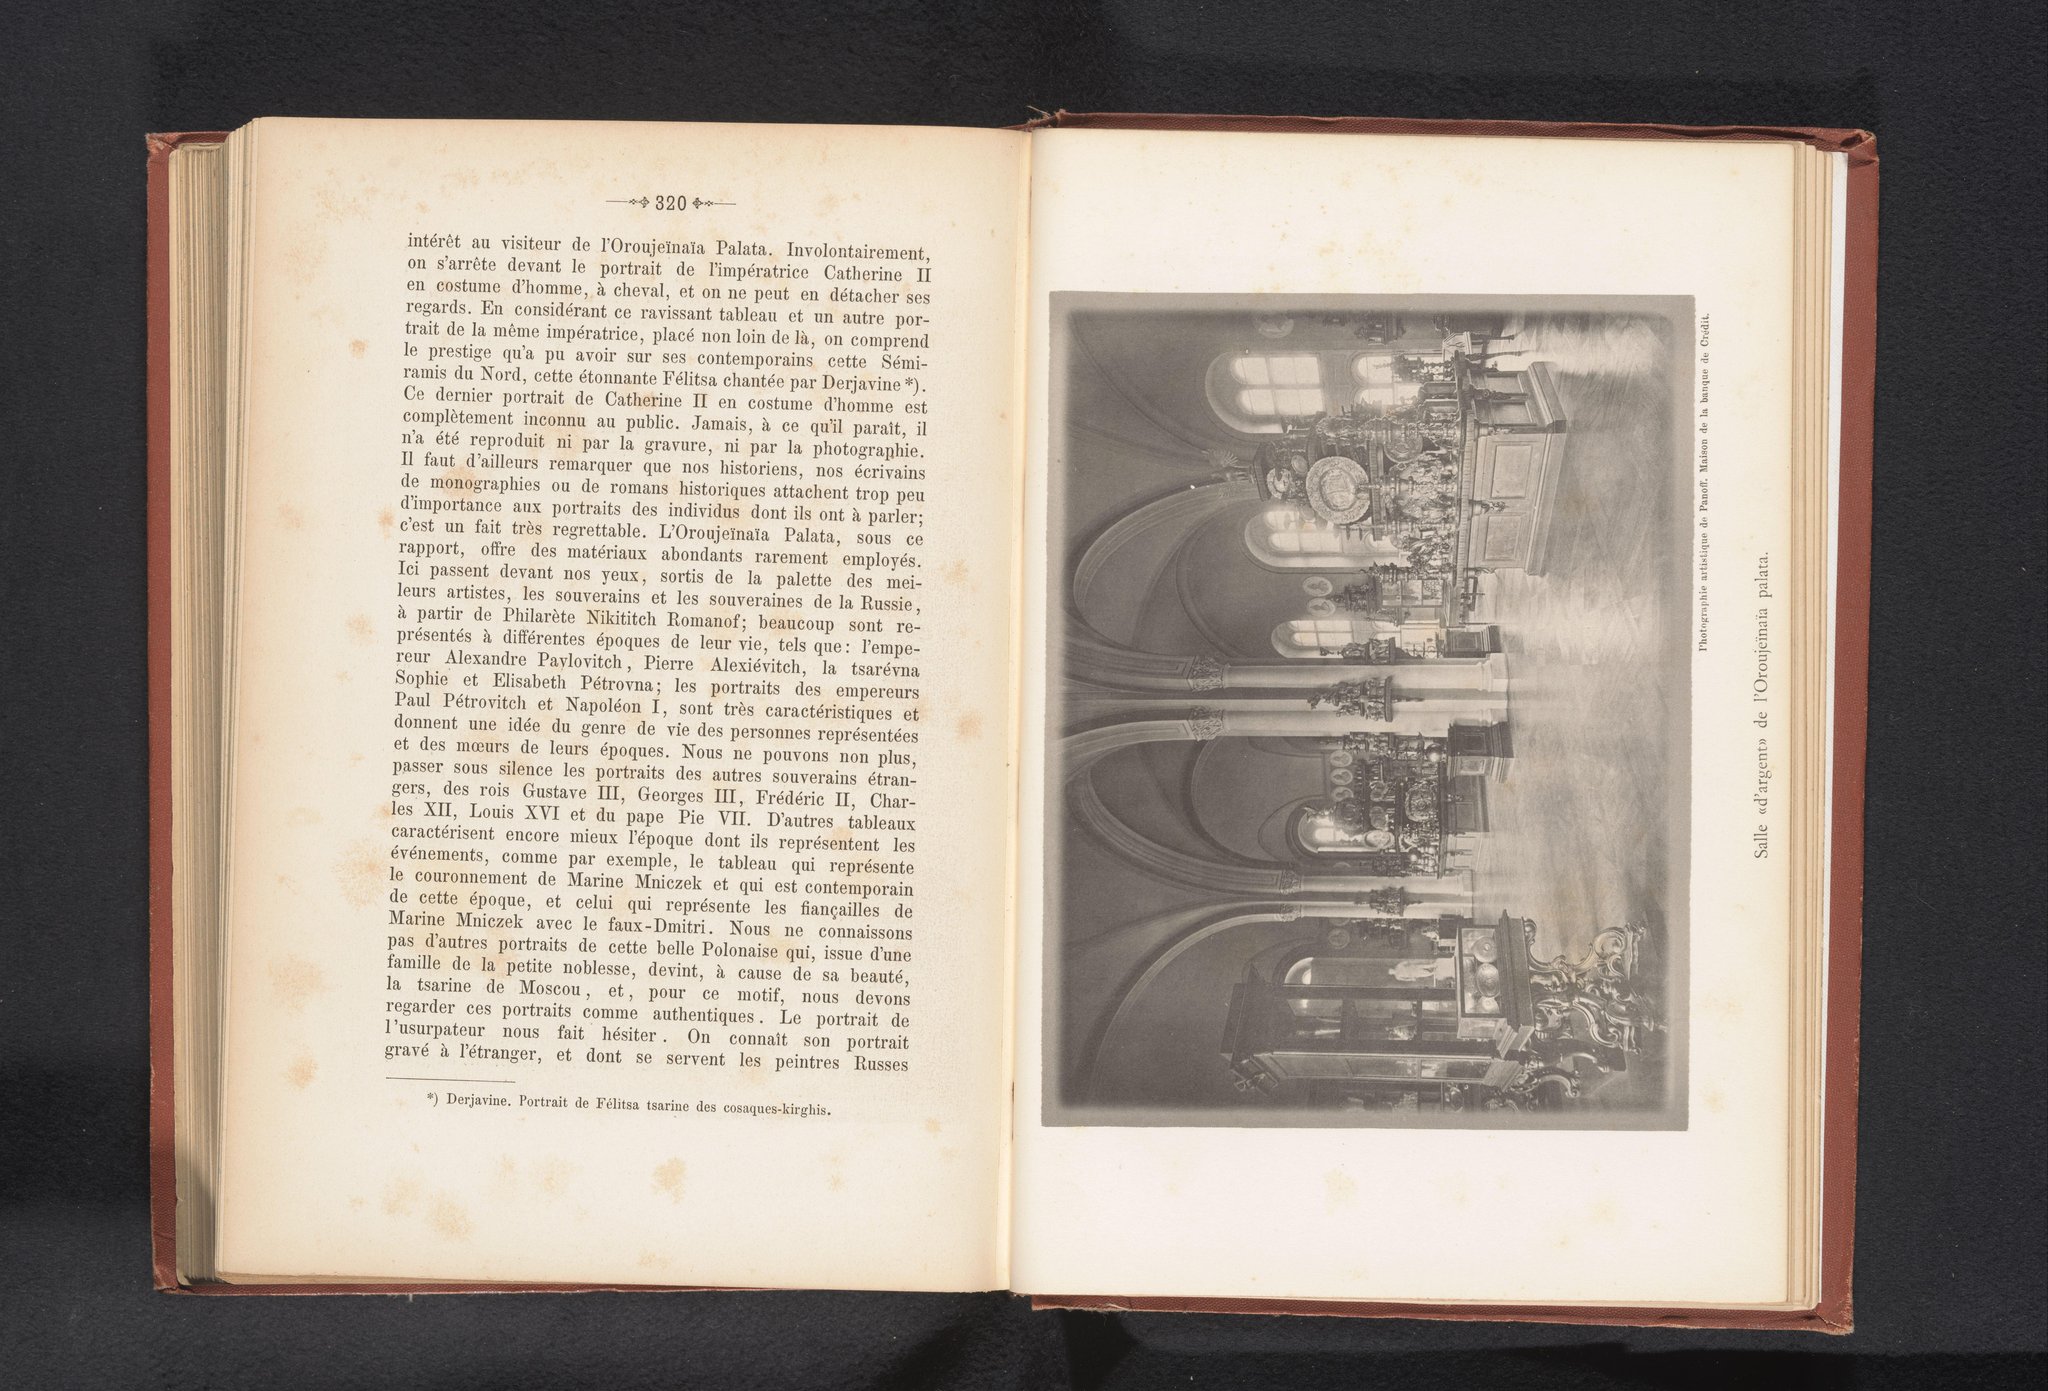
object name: page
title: Salle d'argent de l'Oroujeïnaïa palata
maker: Anonymous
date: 1873-1883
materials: paper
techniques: photograph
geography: kremlin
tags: palace, permanent exhibition, museum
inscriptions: name: ‘Photographie artistique de Panoff. Maison de la banque de Crédit.’